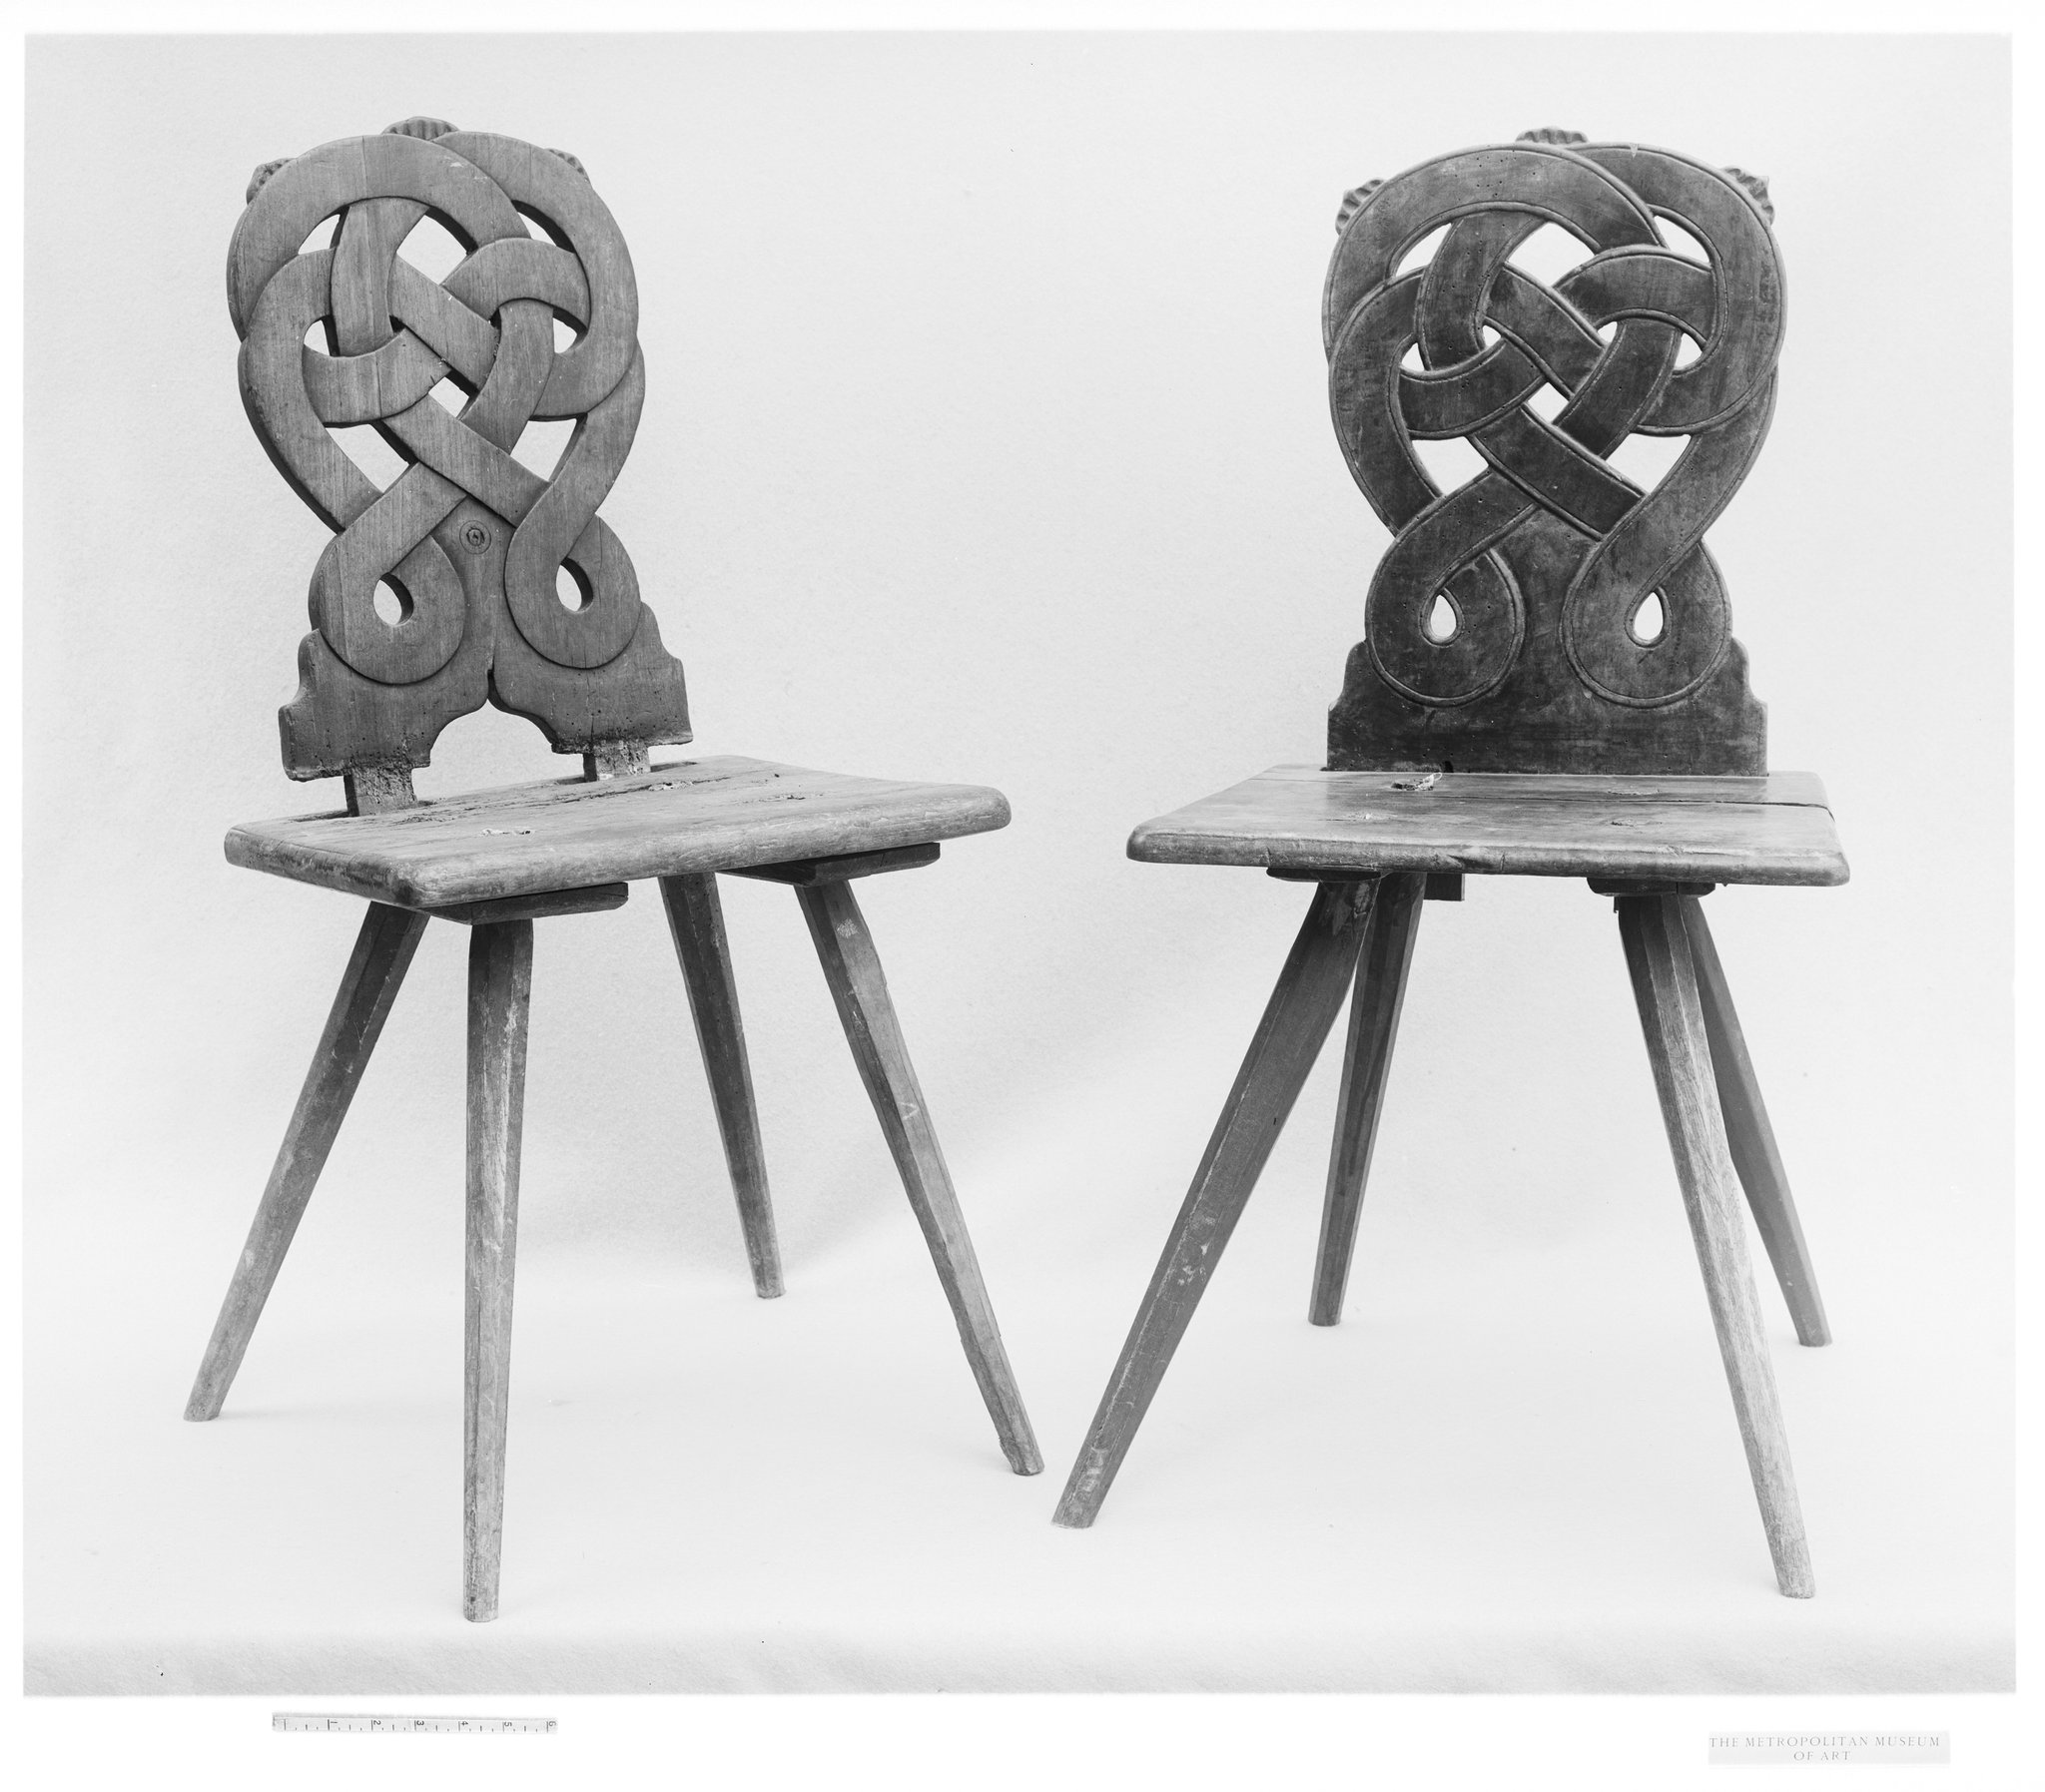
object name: chair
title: Pair of chairs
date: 1701-1800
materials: wood